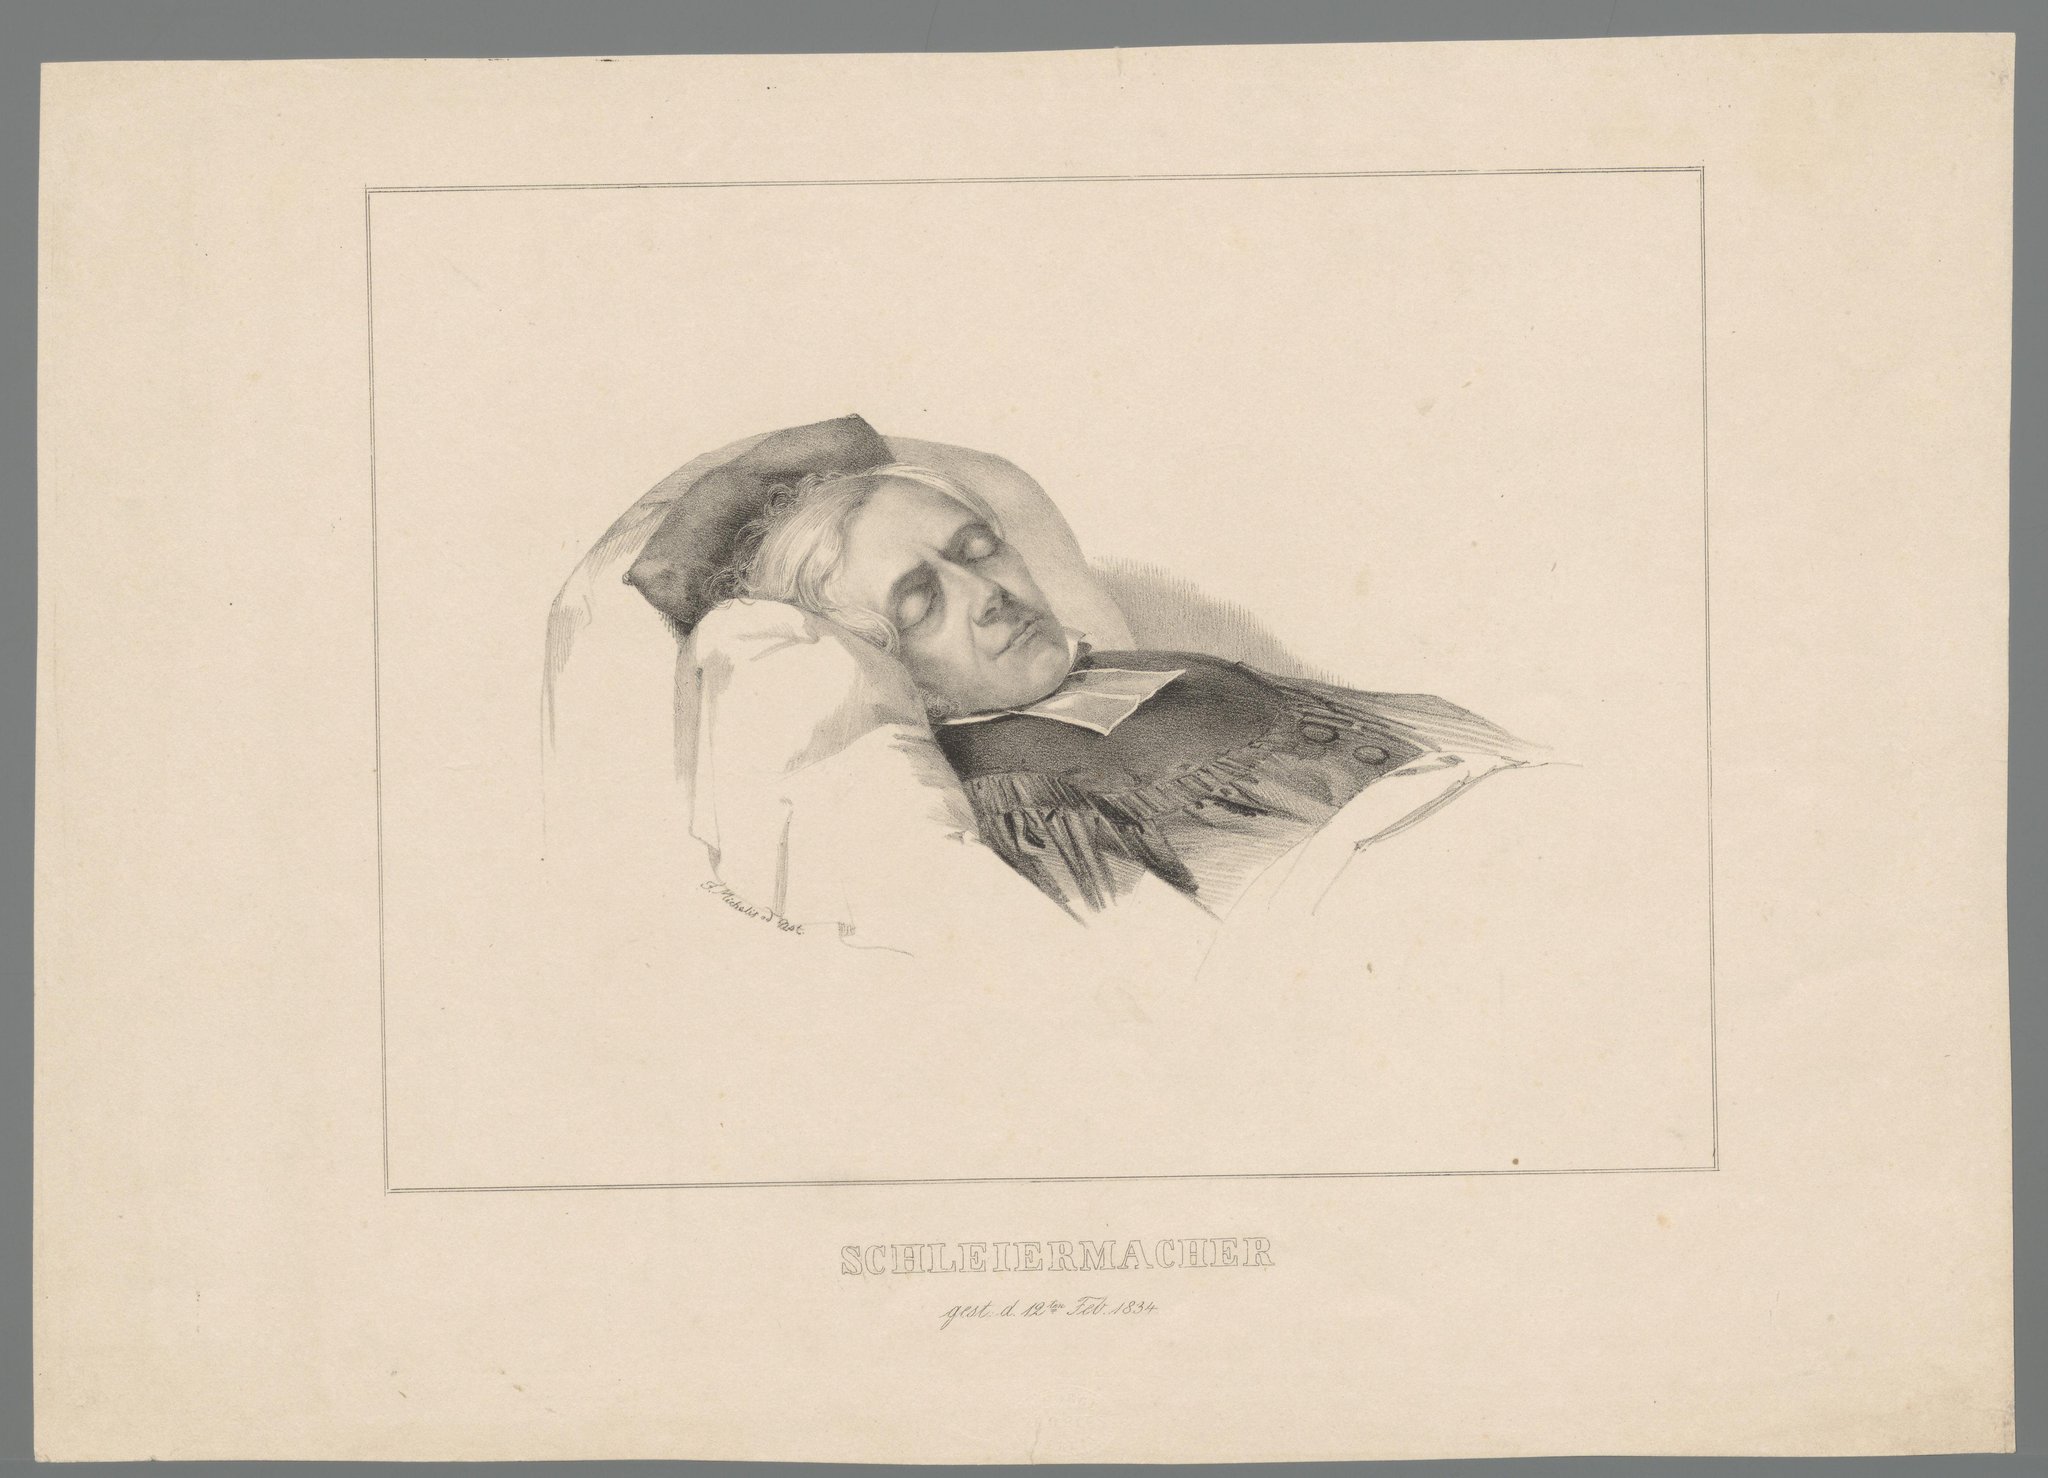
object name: print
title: Portret van Friedrich Ernst Daniel Schleiermacher op zijn doodsbed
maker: franz michelis (i)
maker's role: print maker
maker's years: 1762-1835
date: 1834-1835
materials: paper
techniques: lithograph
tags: berlin, adult man, deathbed, historical persons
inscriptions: collector's mark: Lugt 2228